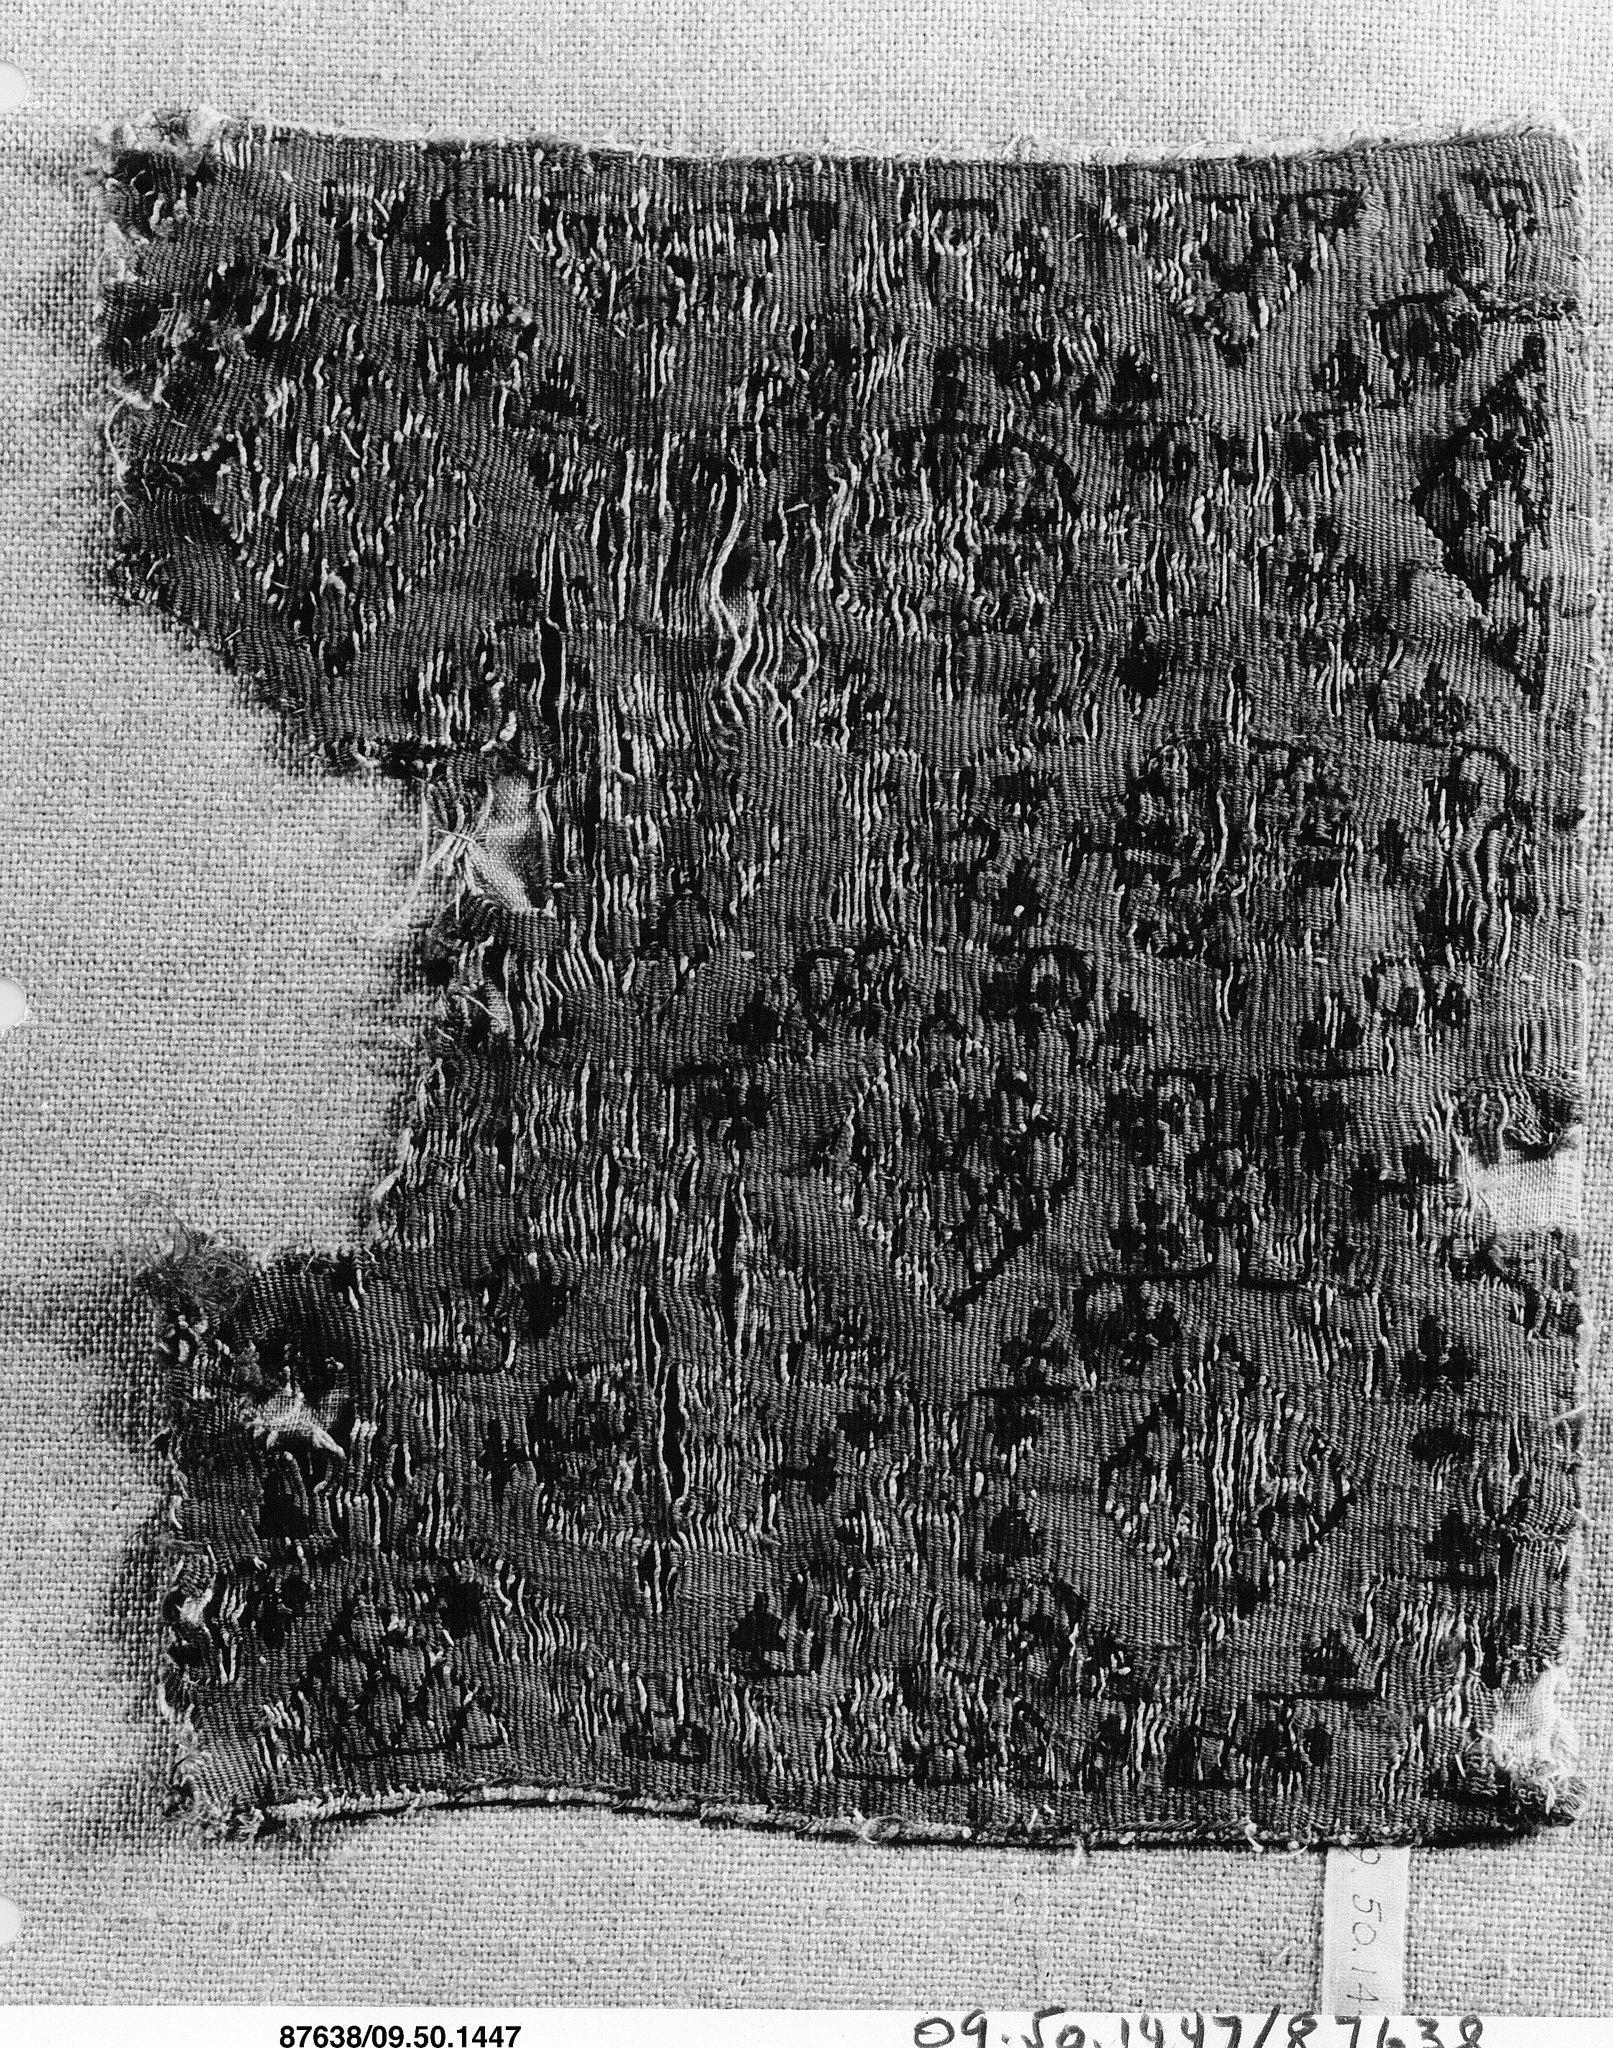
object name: square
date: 501-700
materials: linen, wool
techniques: weave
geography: egypt